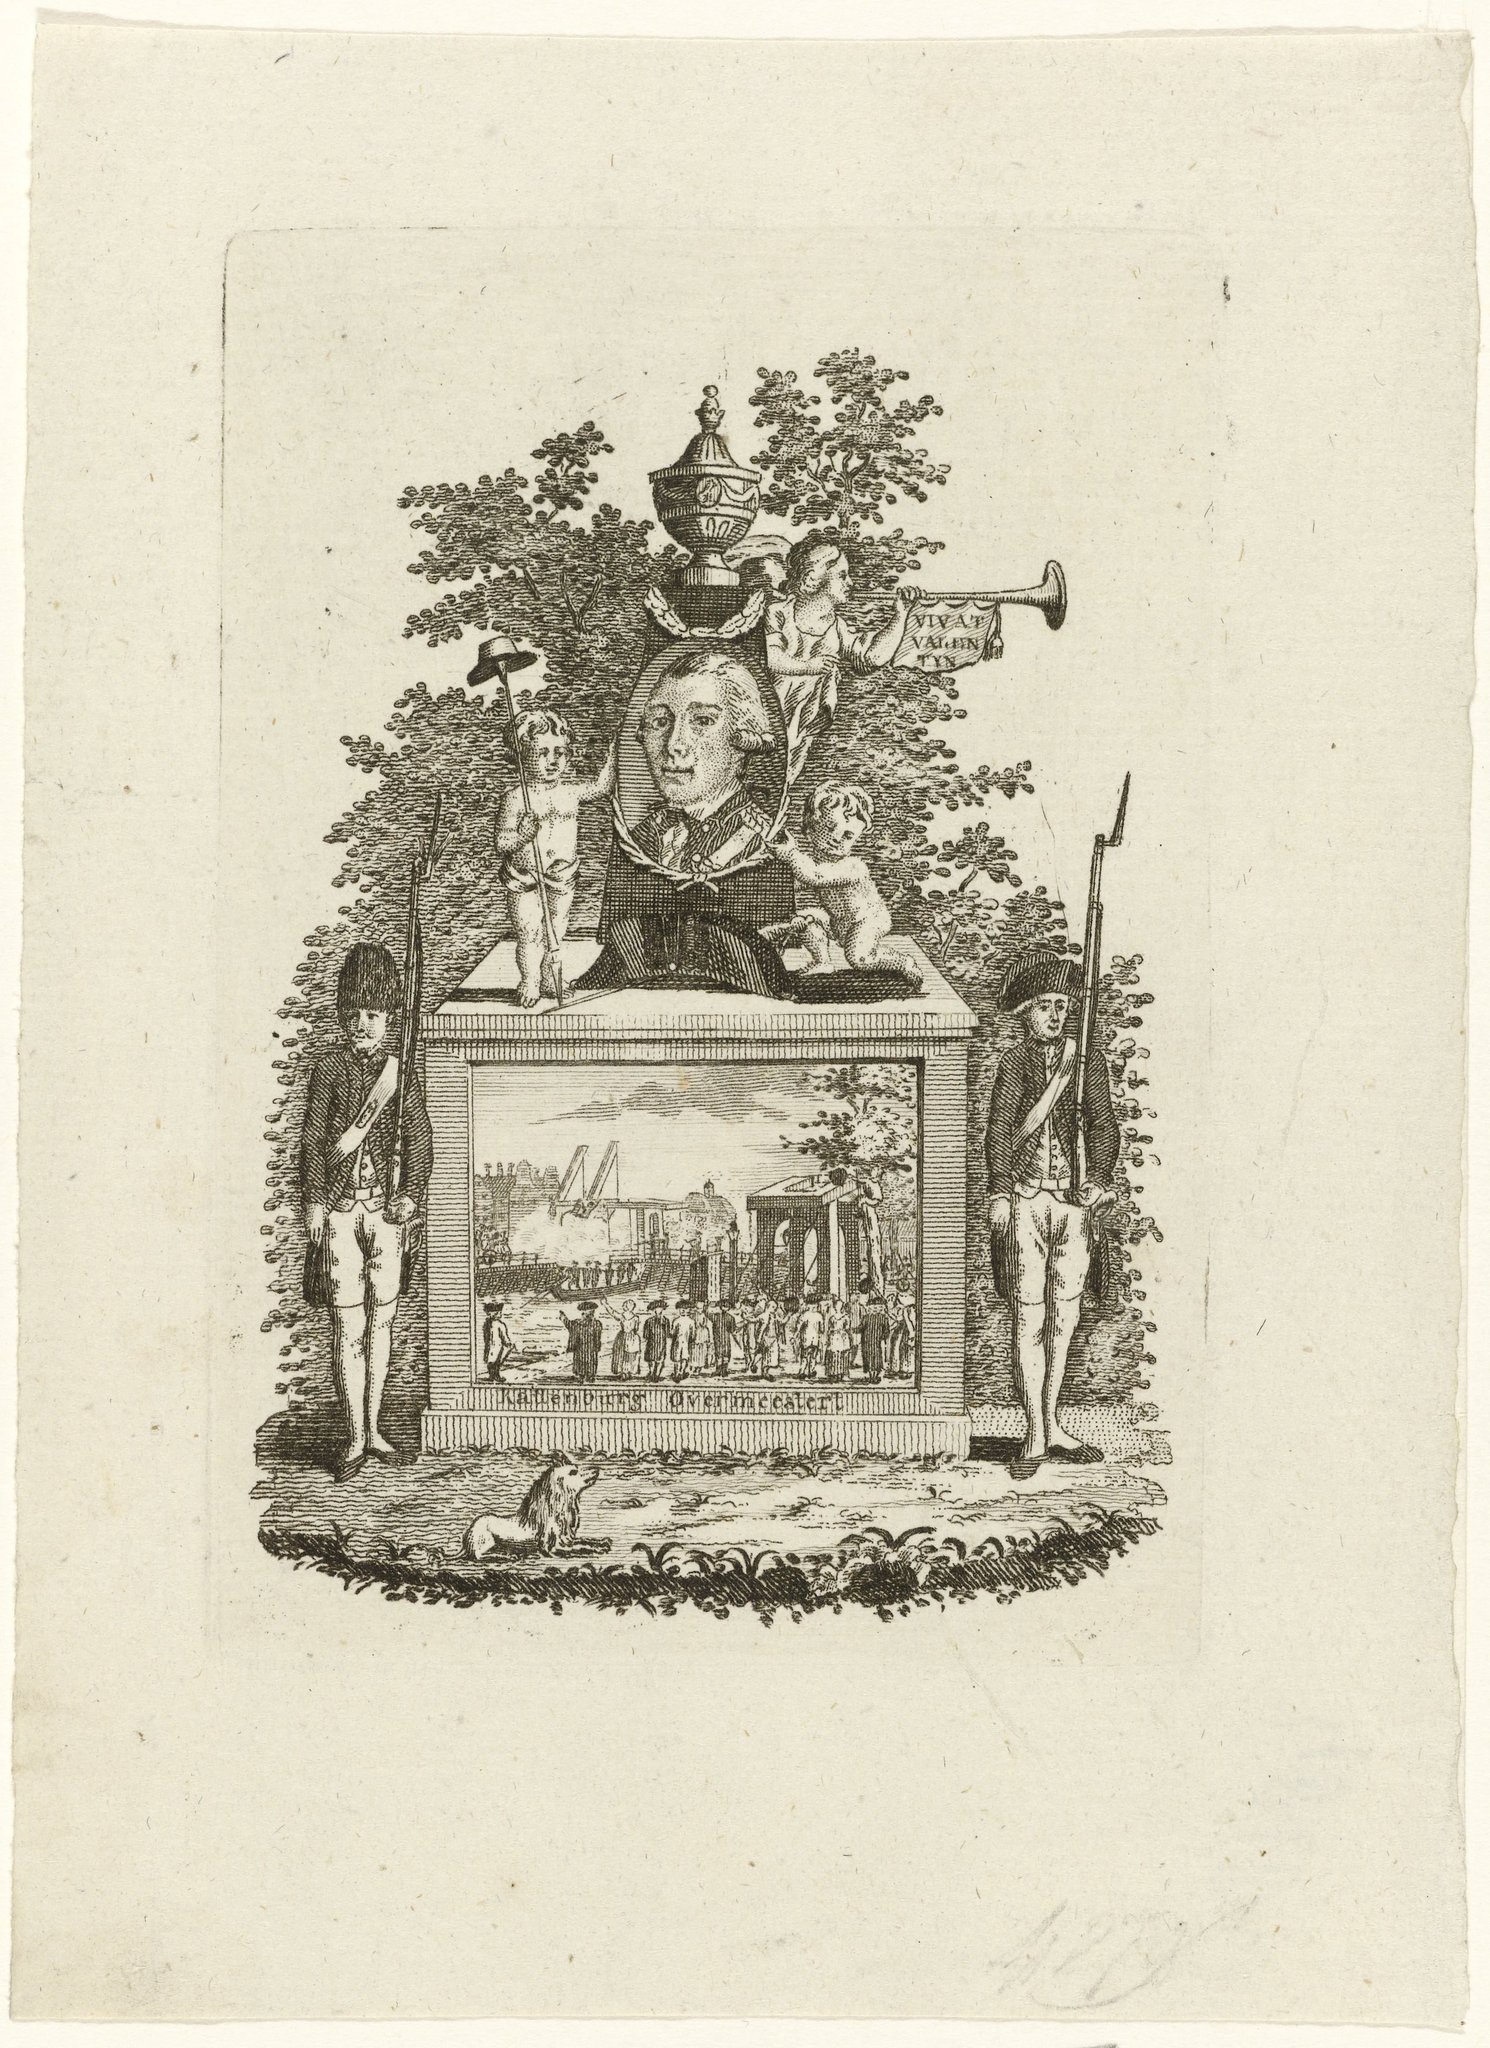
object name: print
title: Monument voor Abraham Valentijn en de verovering van Kattenburg, 1787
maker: Anonymous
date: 1787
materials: paper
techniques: engraving, etching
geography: northern netherlands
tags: battle (+ citizen soldiery, civil guard, citizen militia)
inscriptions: collector's mark: Lugt 2228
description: Allegorie met op een voetstuk een voorstelling van de verovering van Kattenburg op de opstandige Oranjegezinden door de gewapende Amsterdamse burgers op 30 mei 1787. Op het monument een portretje van kolonel Abraham Valentijn die de leiding had bij deze actie, met genieën, de Faam en twee soldaten op wacht.